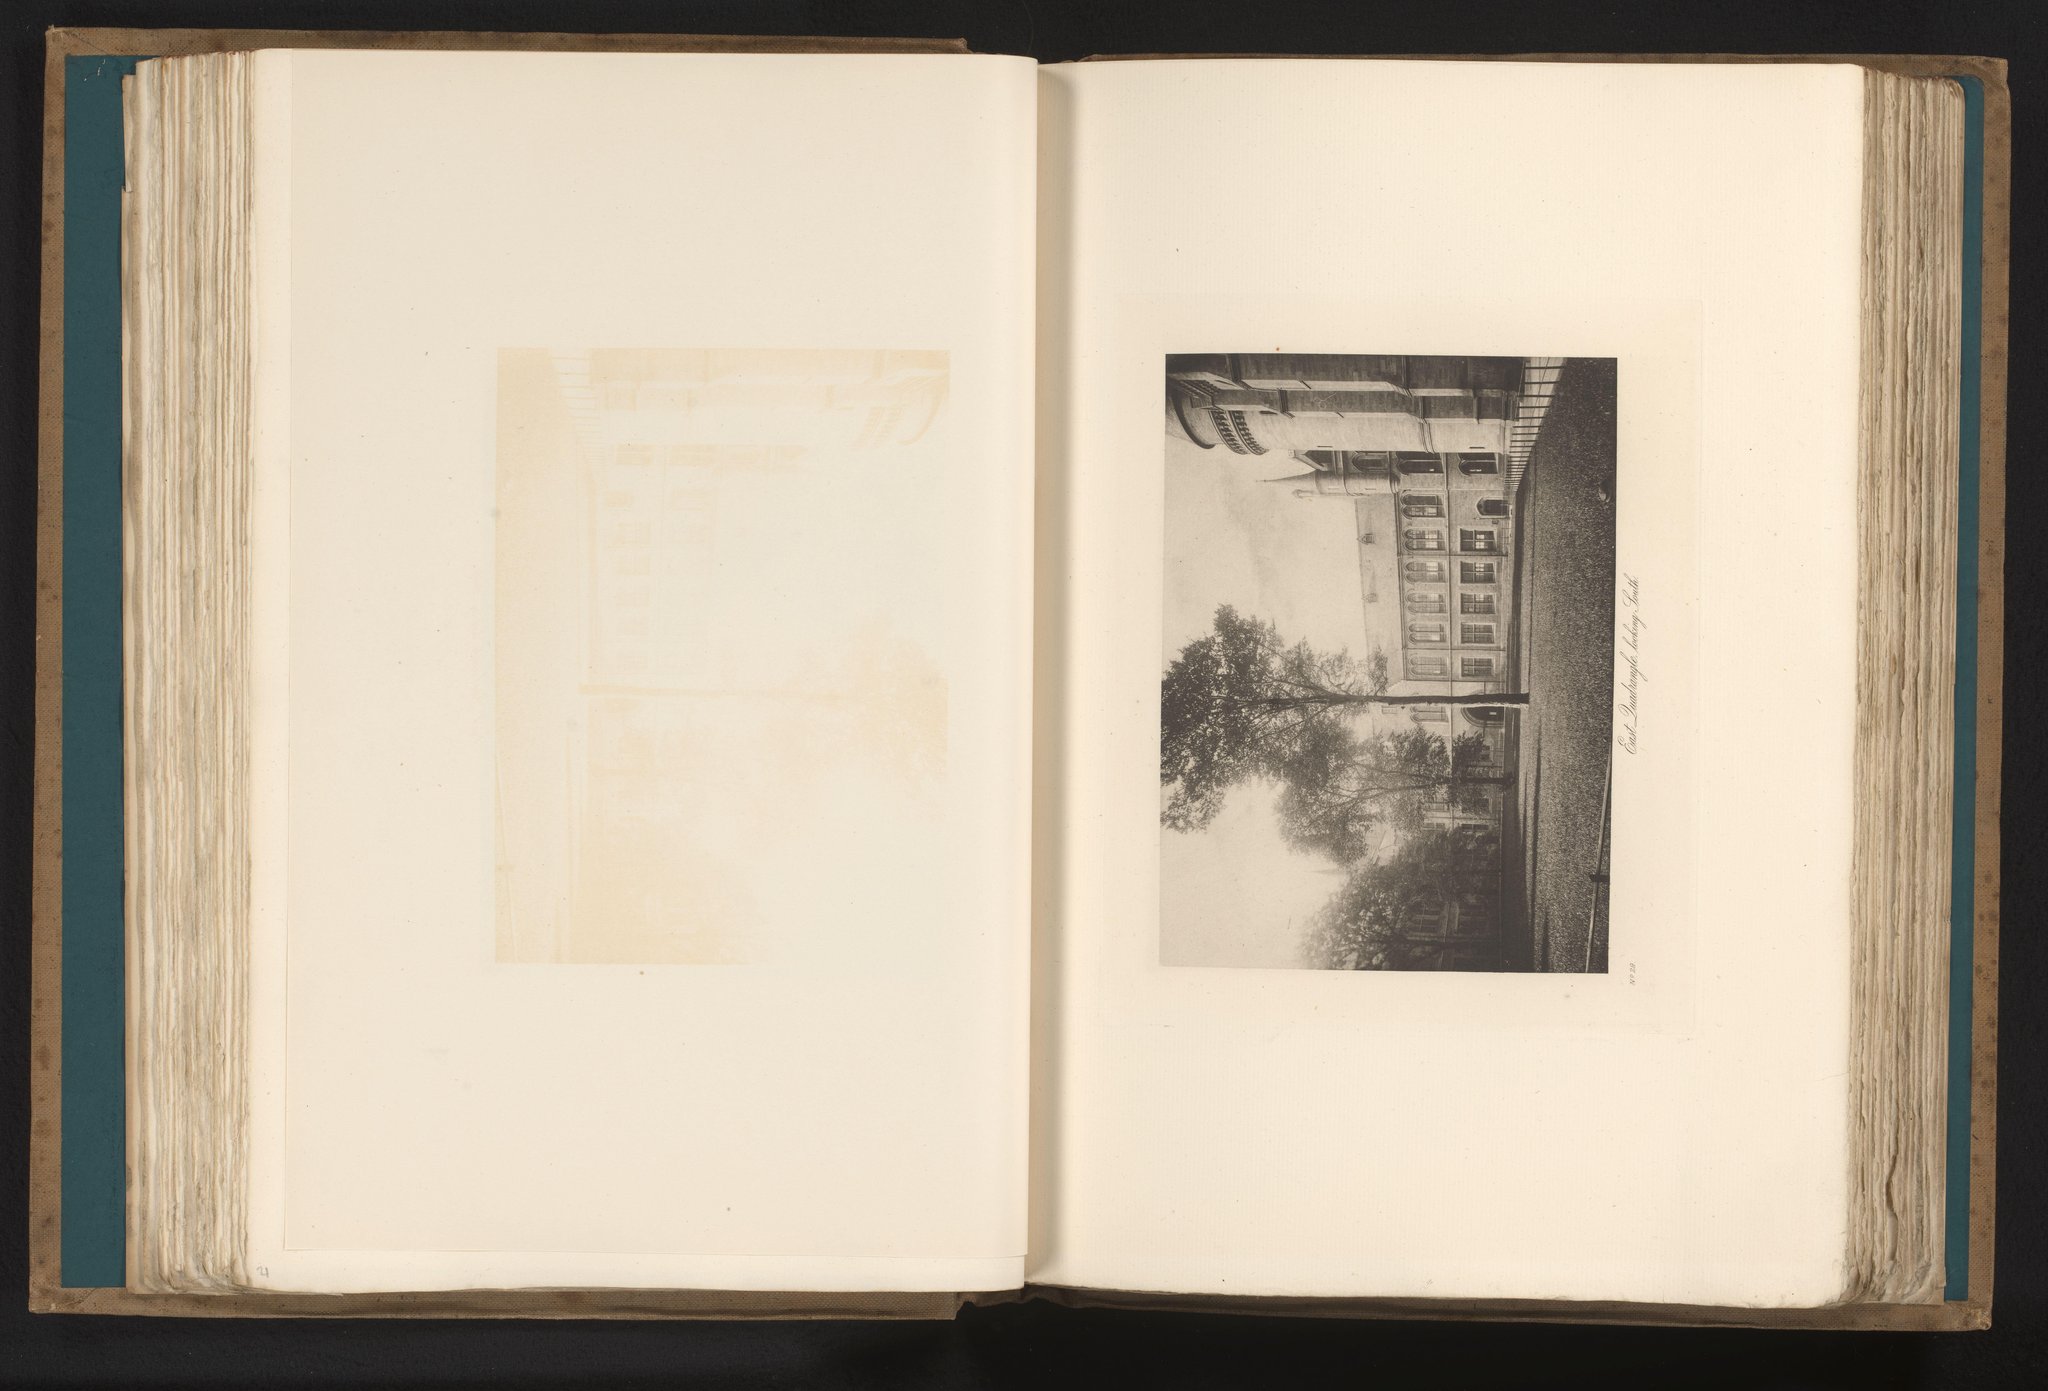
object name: photomechanical print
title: East Quadrangle, looking South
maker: Anonymous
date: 1886-1891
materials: paper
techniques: photoaquatint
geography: glasgow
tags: university (+ building ~ education, tuition), courtyard, glasgow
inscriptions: inscription: ‘No.29’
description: Prent op vierentwintigste ongenummerde pagina na pagina xxxiii.